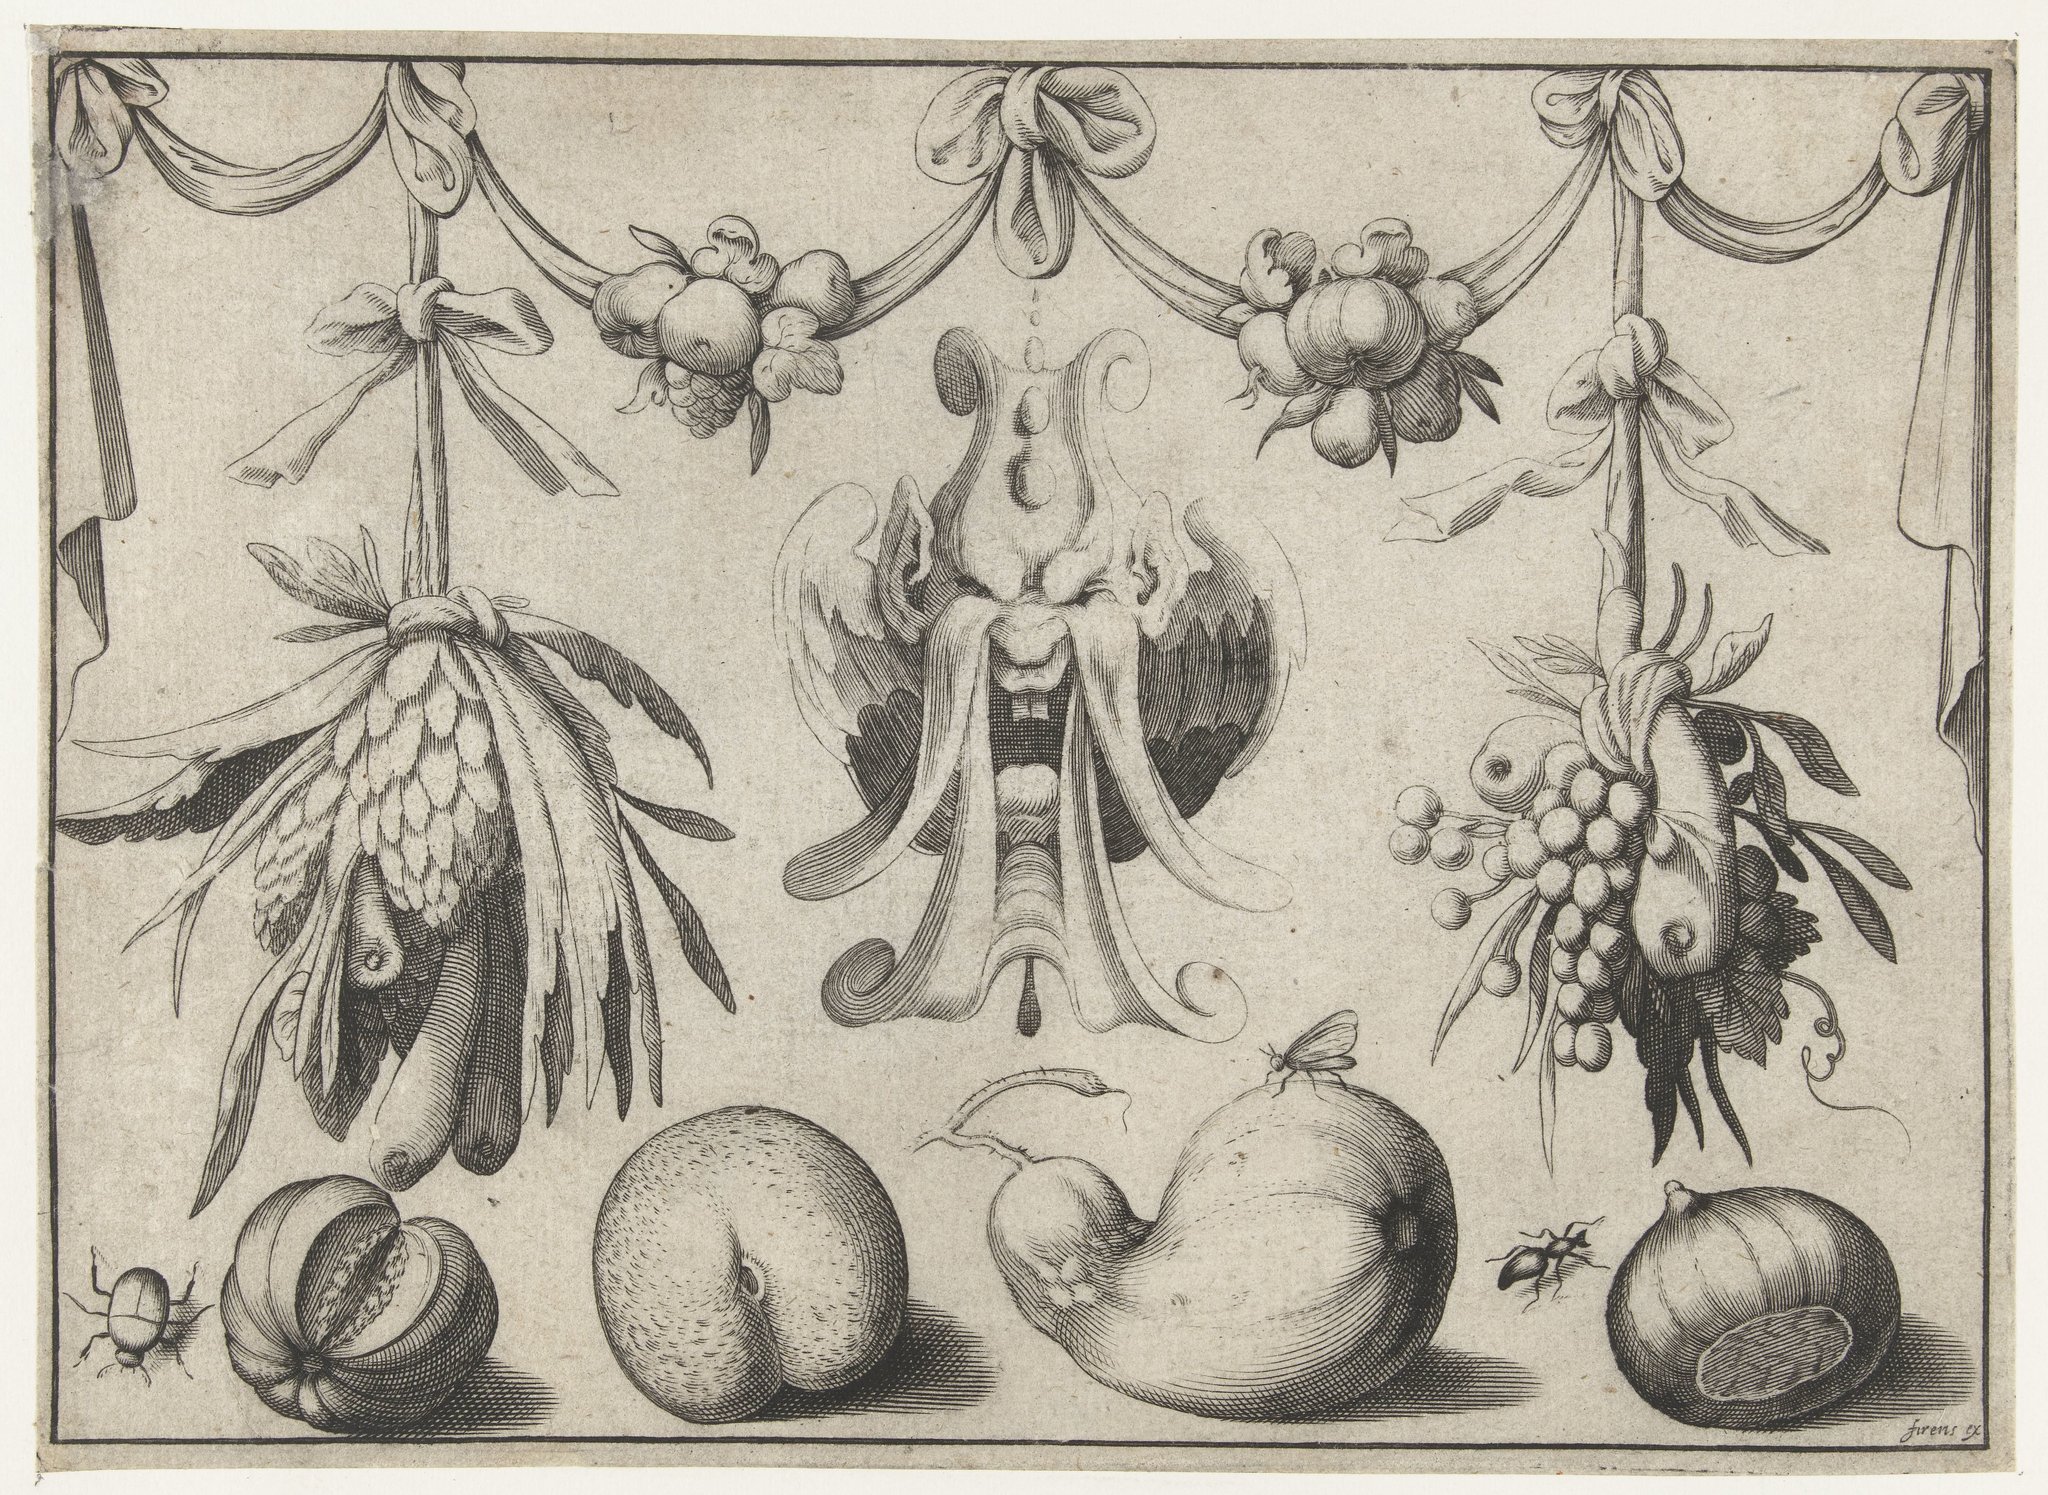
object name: ornament print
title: Guirlandes van vruchten en maskers omgeven door een kaderlijn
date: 1604-1616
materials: paper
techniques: engraving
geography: paris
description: Aan de guirlande hangen twee trossen fruit. Blad is onderdeel van een serie van 3 bladen. Onderaan liggen vruchten.